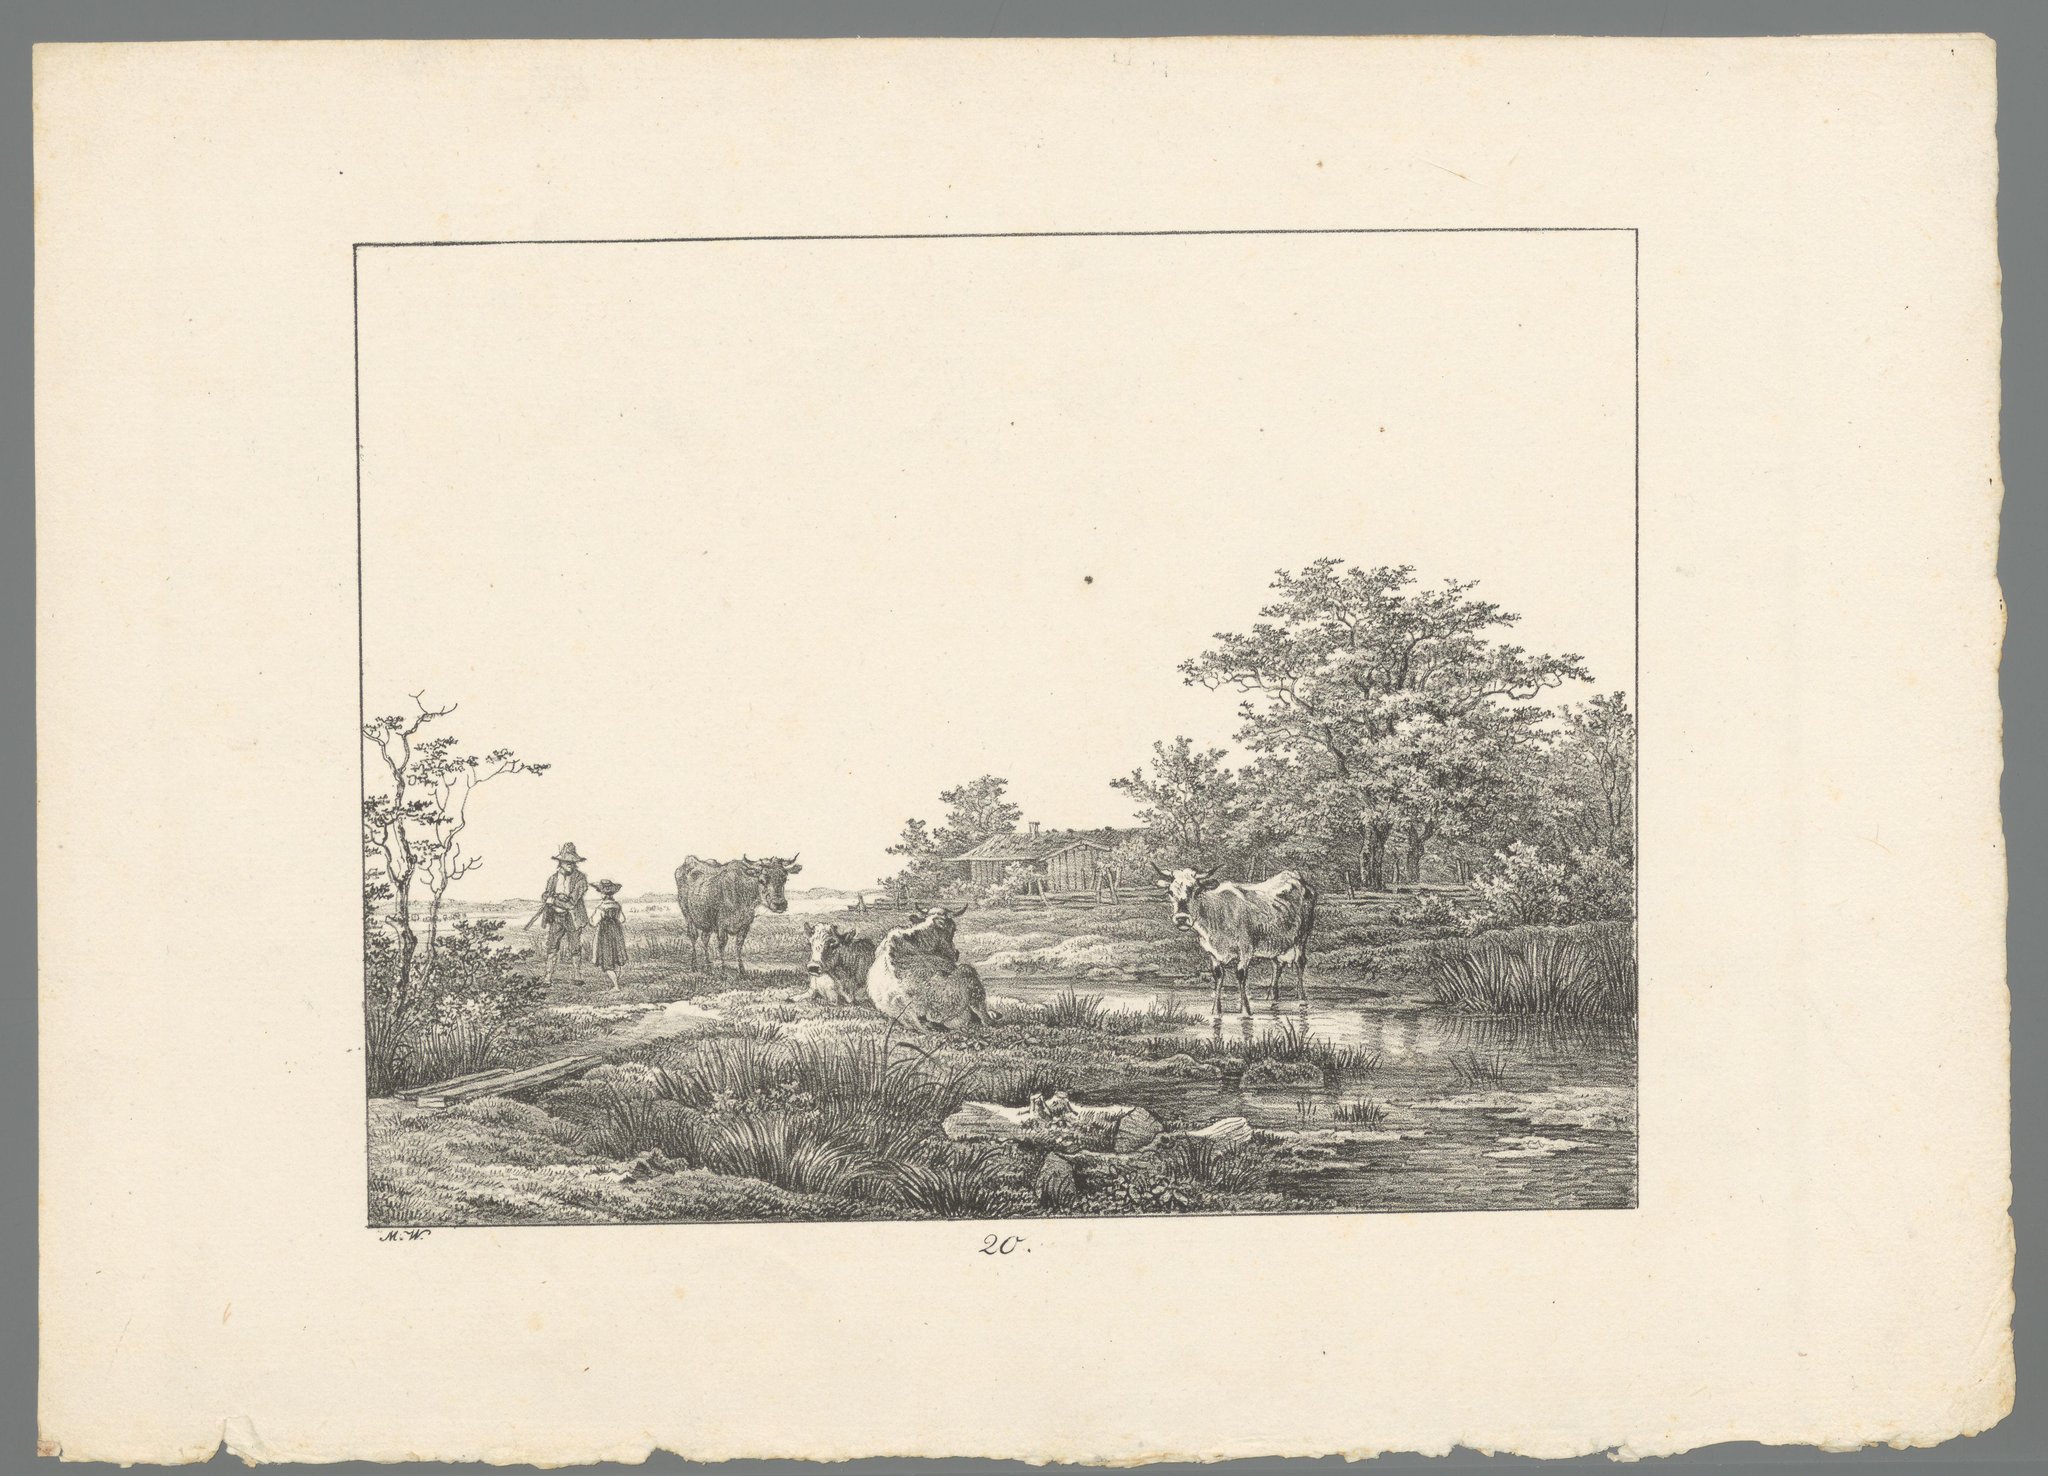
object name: print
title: Vier koeien in een landschap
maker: max josef wagenbauer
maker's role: print maker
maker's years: 1774-1829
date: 1823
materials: paper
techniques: lithograph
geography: munich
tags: herding, herdsman, herdswoman, shepherd, shepherdess, cowherd, etc., bovine cattle, landscapes in the temperate zone (+ landscape with figures, staffage)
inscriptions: collector's mark: Lugt 2760, collector's mark: Lugt 2228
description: Prent behoort tot het eerste deel van de serie 'Vorlagen für Landschaft-zeichner'. Dit eerste deel bevat twintig prenten.